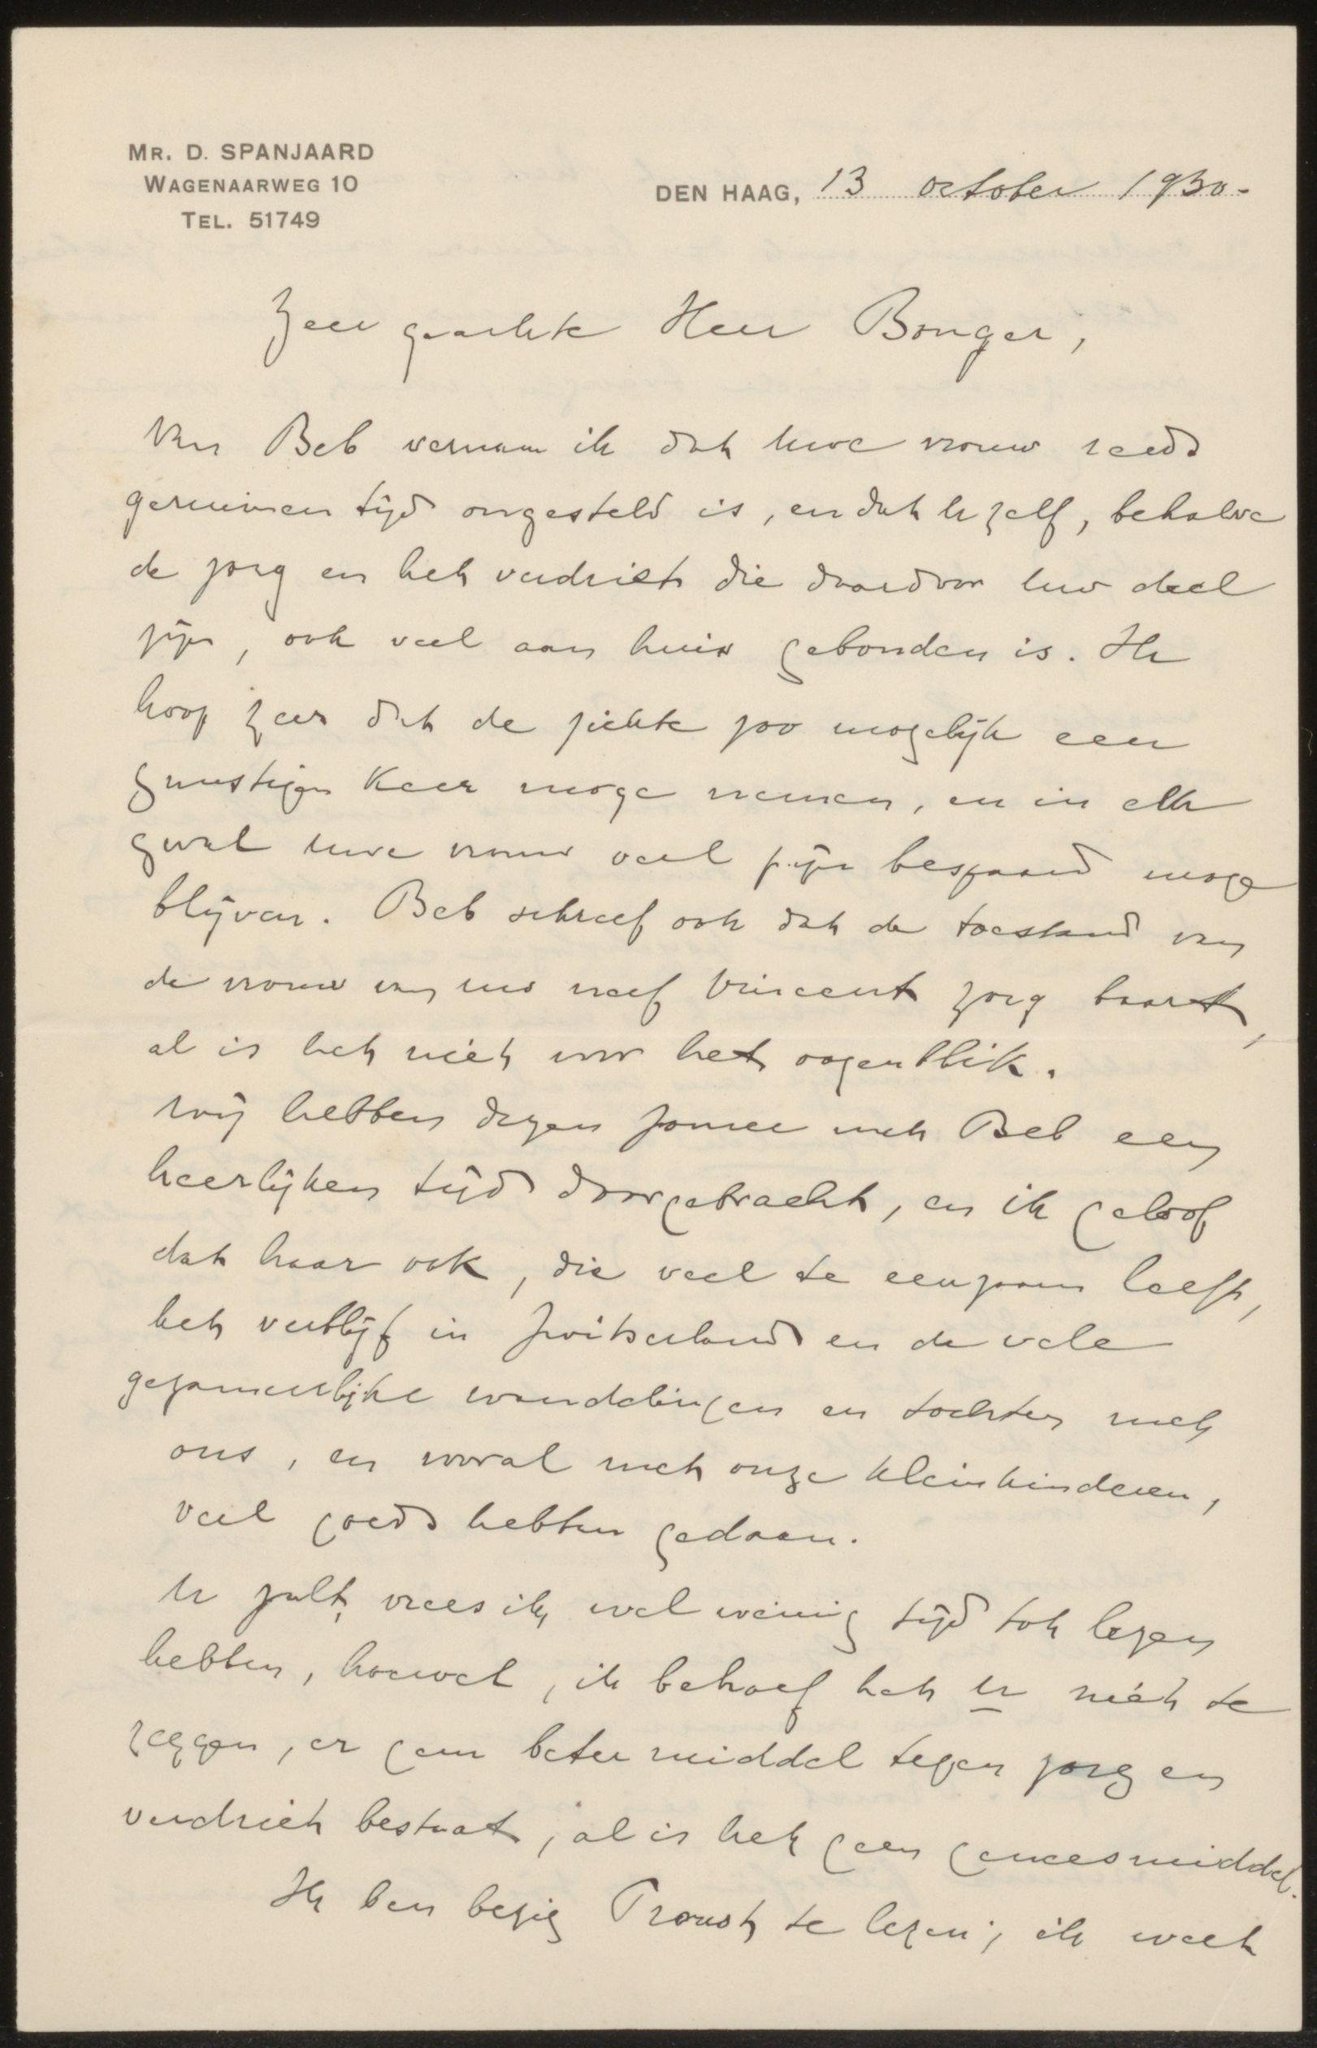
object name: letter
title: Brief aan Andries Bonger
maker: d. spanjaard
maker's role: jurist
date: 1930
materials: ink, paper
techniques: pen, printing, writing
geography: the hague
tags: andries bonger, literature ~ arts, diseases, switzerland